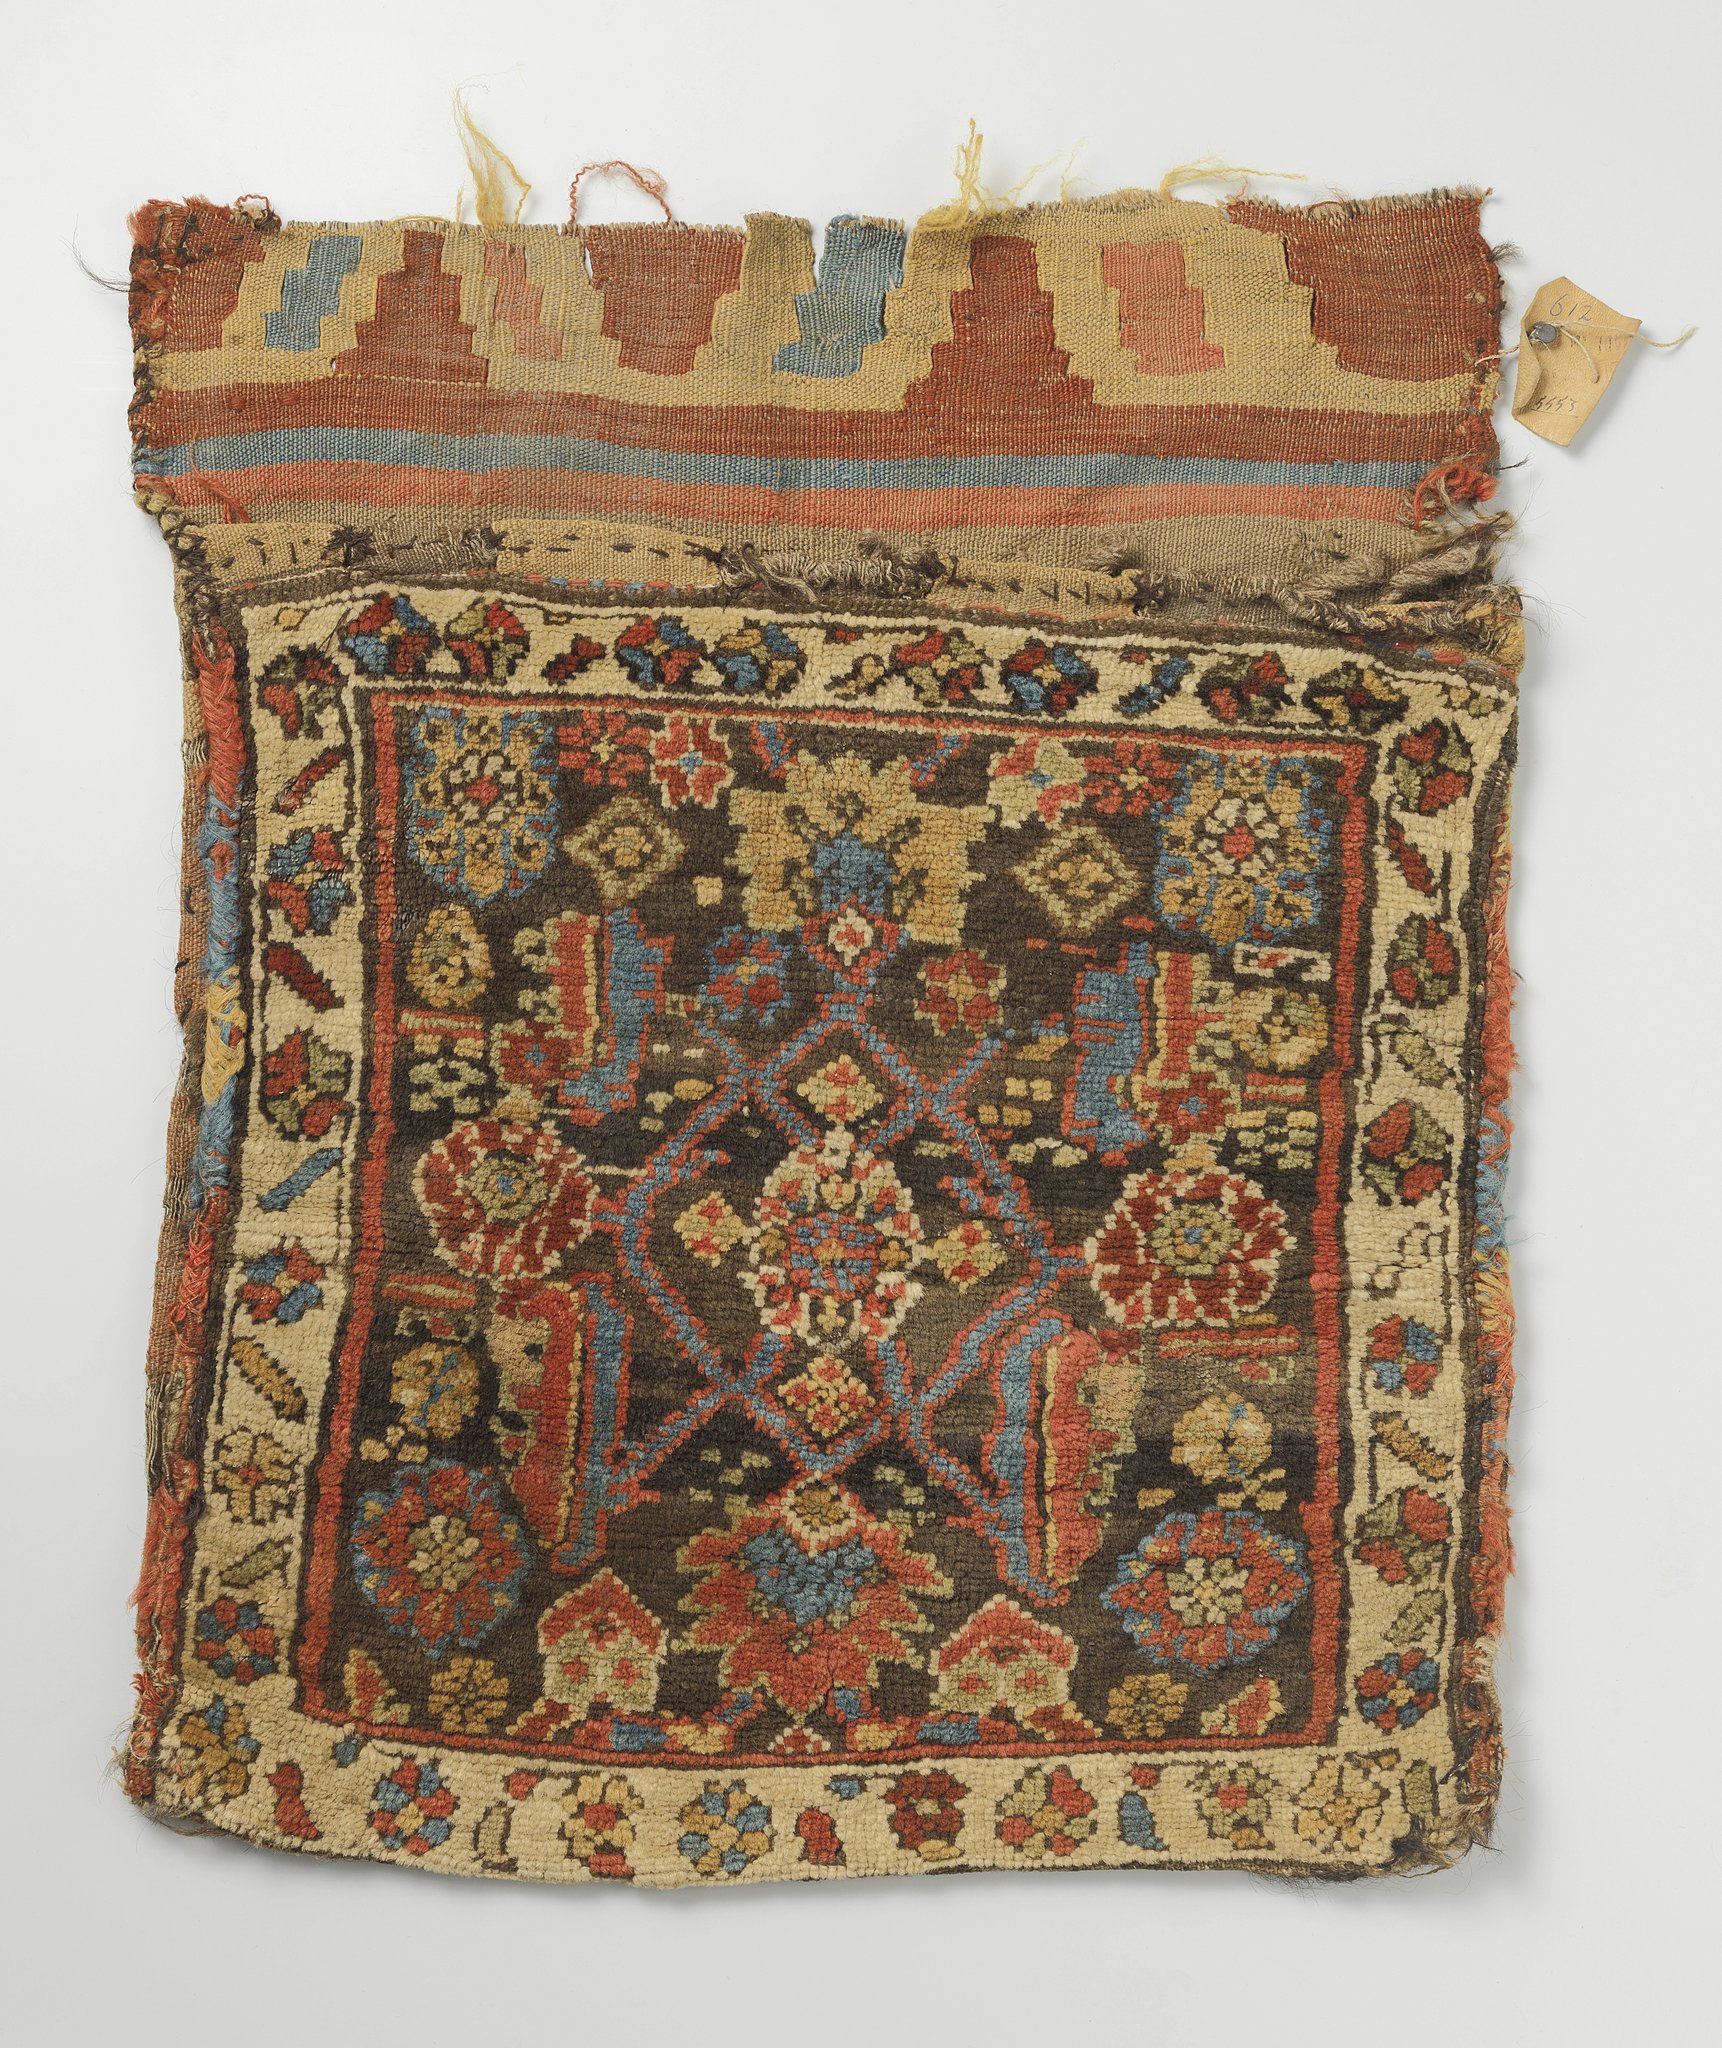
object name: zadeltas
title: Zadeltas, versierd met gekruiste ranken en bladeren en vier rozetbloemen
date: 1800-1900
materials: animal fiber, wool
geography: kurdistan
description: Zadeltas, Kurdistan. Het middenvled is versierd met gekruiste ranken met bladeren die een ruit vormen. Uit de middenruit komen vier rozetbloemen. Rand met rozen en bladeren. Aan een zijde een baard met splitten, waartegenover sluitlussen van geitenhaar op de achterzijde. Achterzijde van vlak weefsel met dwarsstrepen.